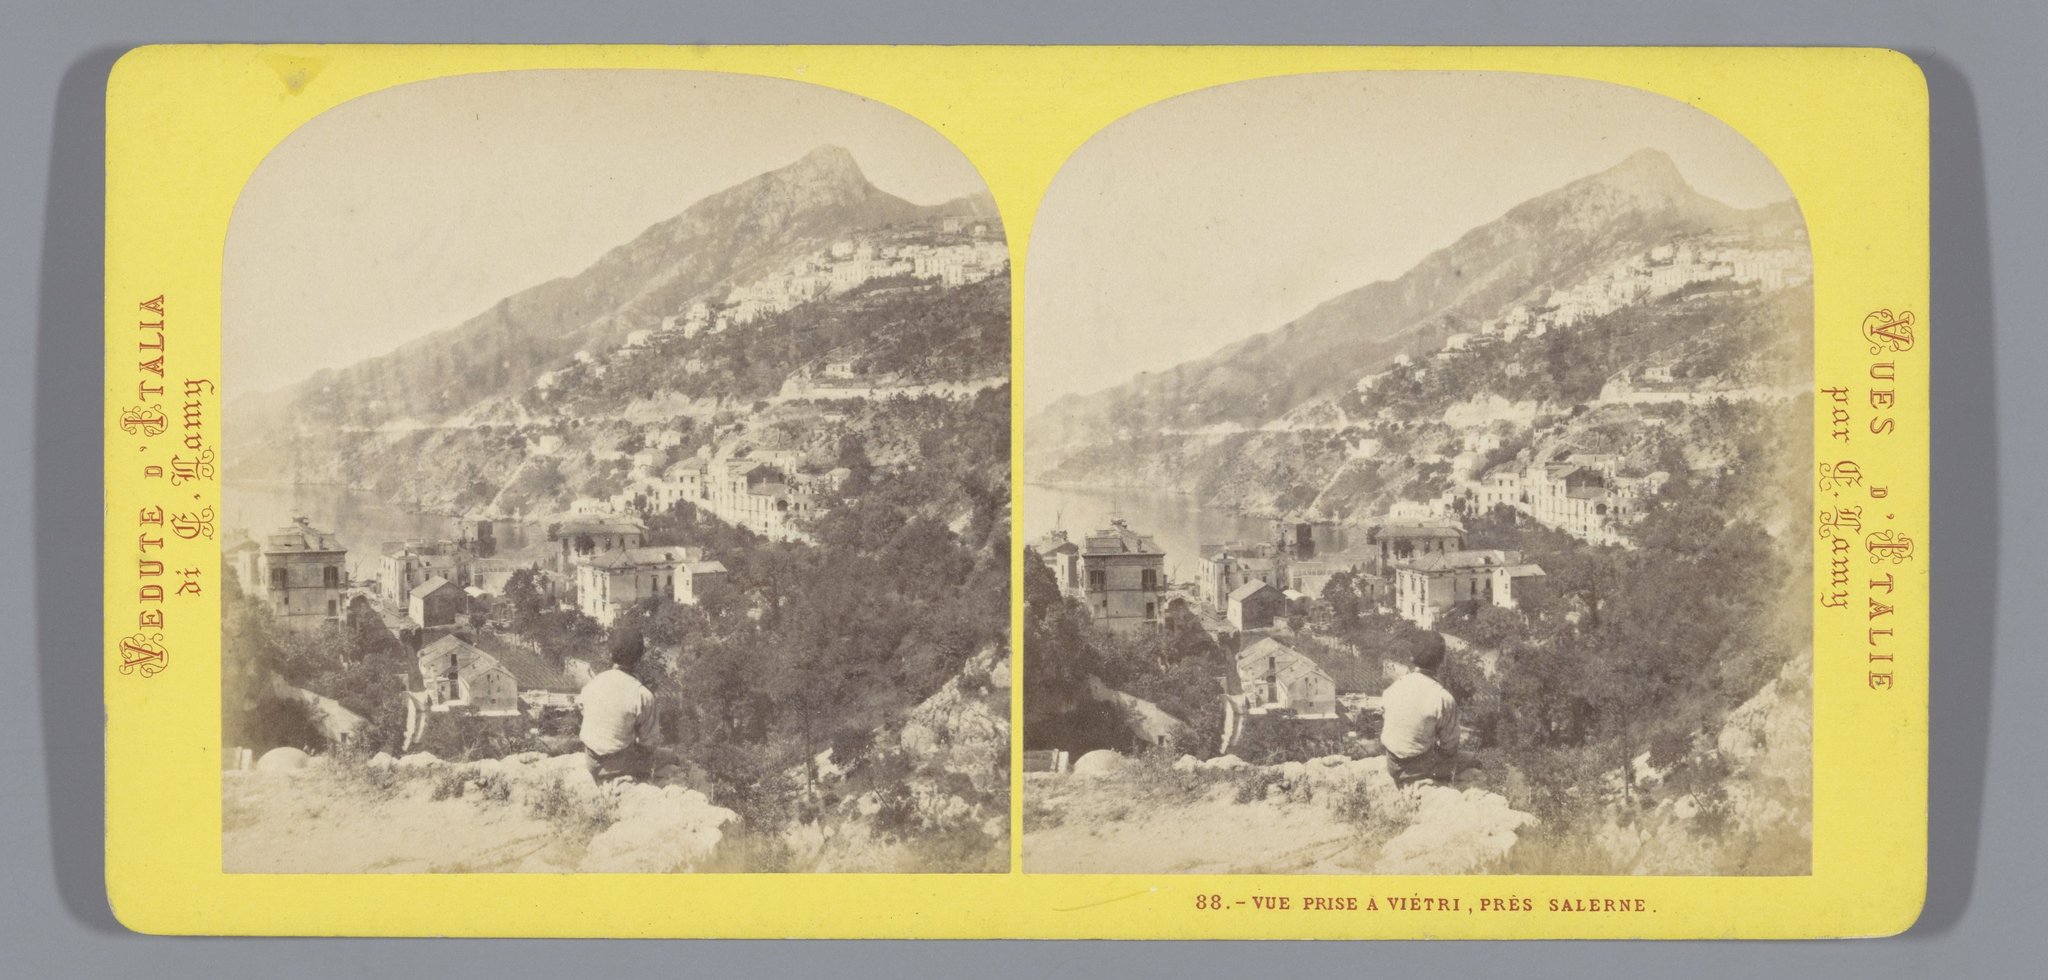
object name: stereograph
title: Vedute d'Italia / Vues d'Italie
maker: ernest eléonor pierre lamy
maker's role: publisher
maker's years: 1828-1900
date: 1861-1878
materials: cardboard, paper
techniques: albumen print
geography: vietri sul mare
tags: gulf, bay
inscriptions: number: ‘88.’